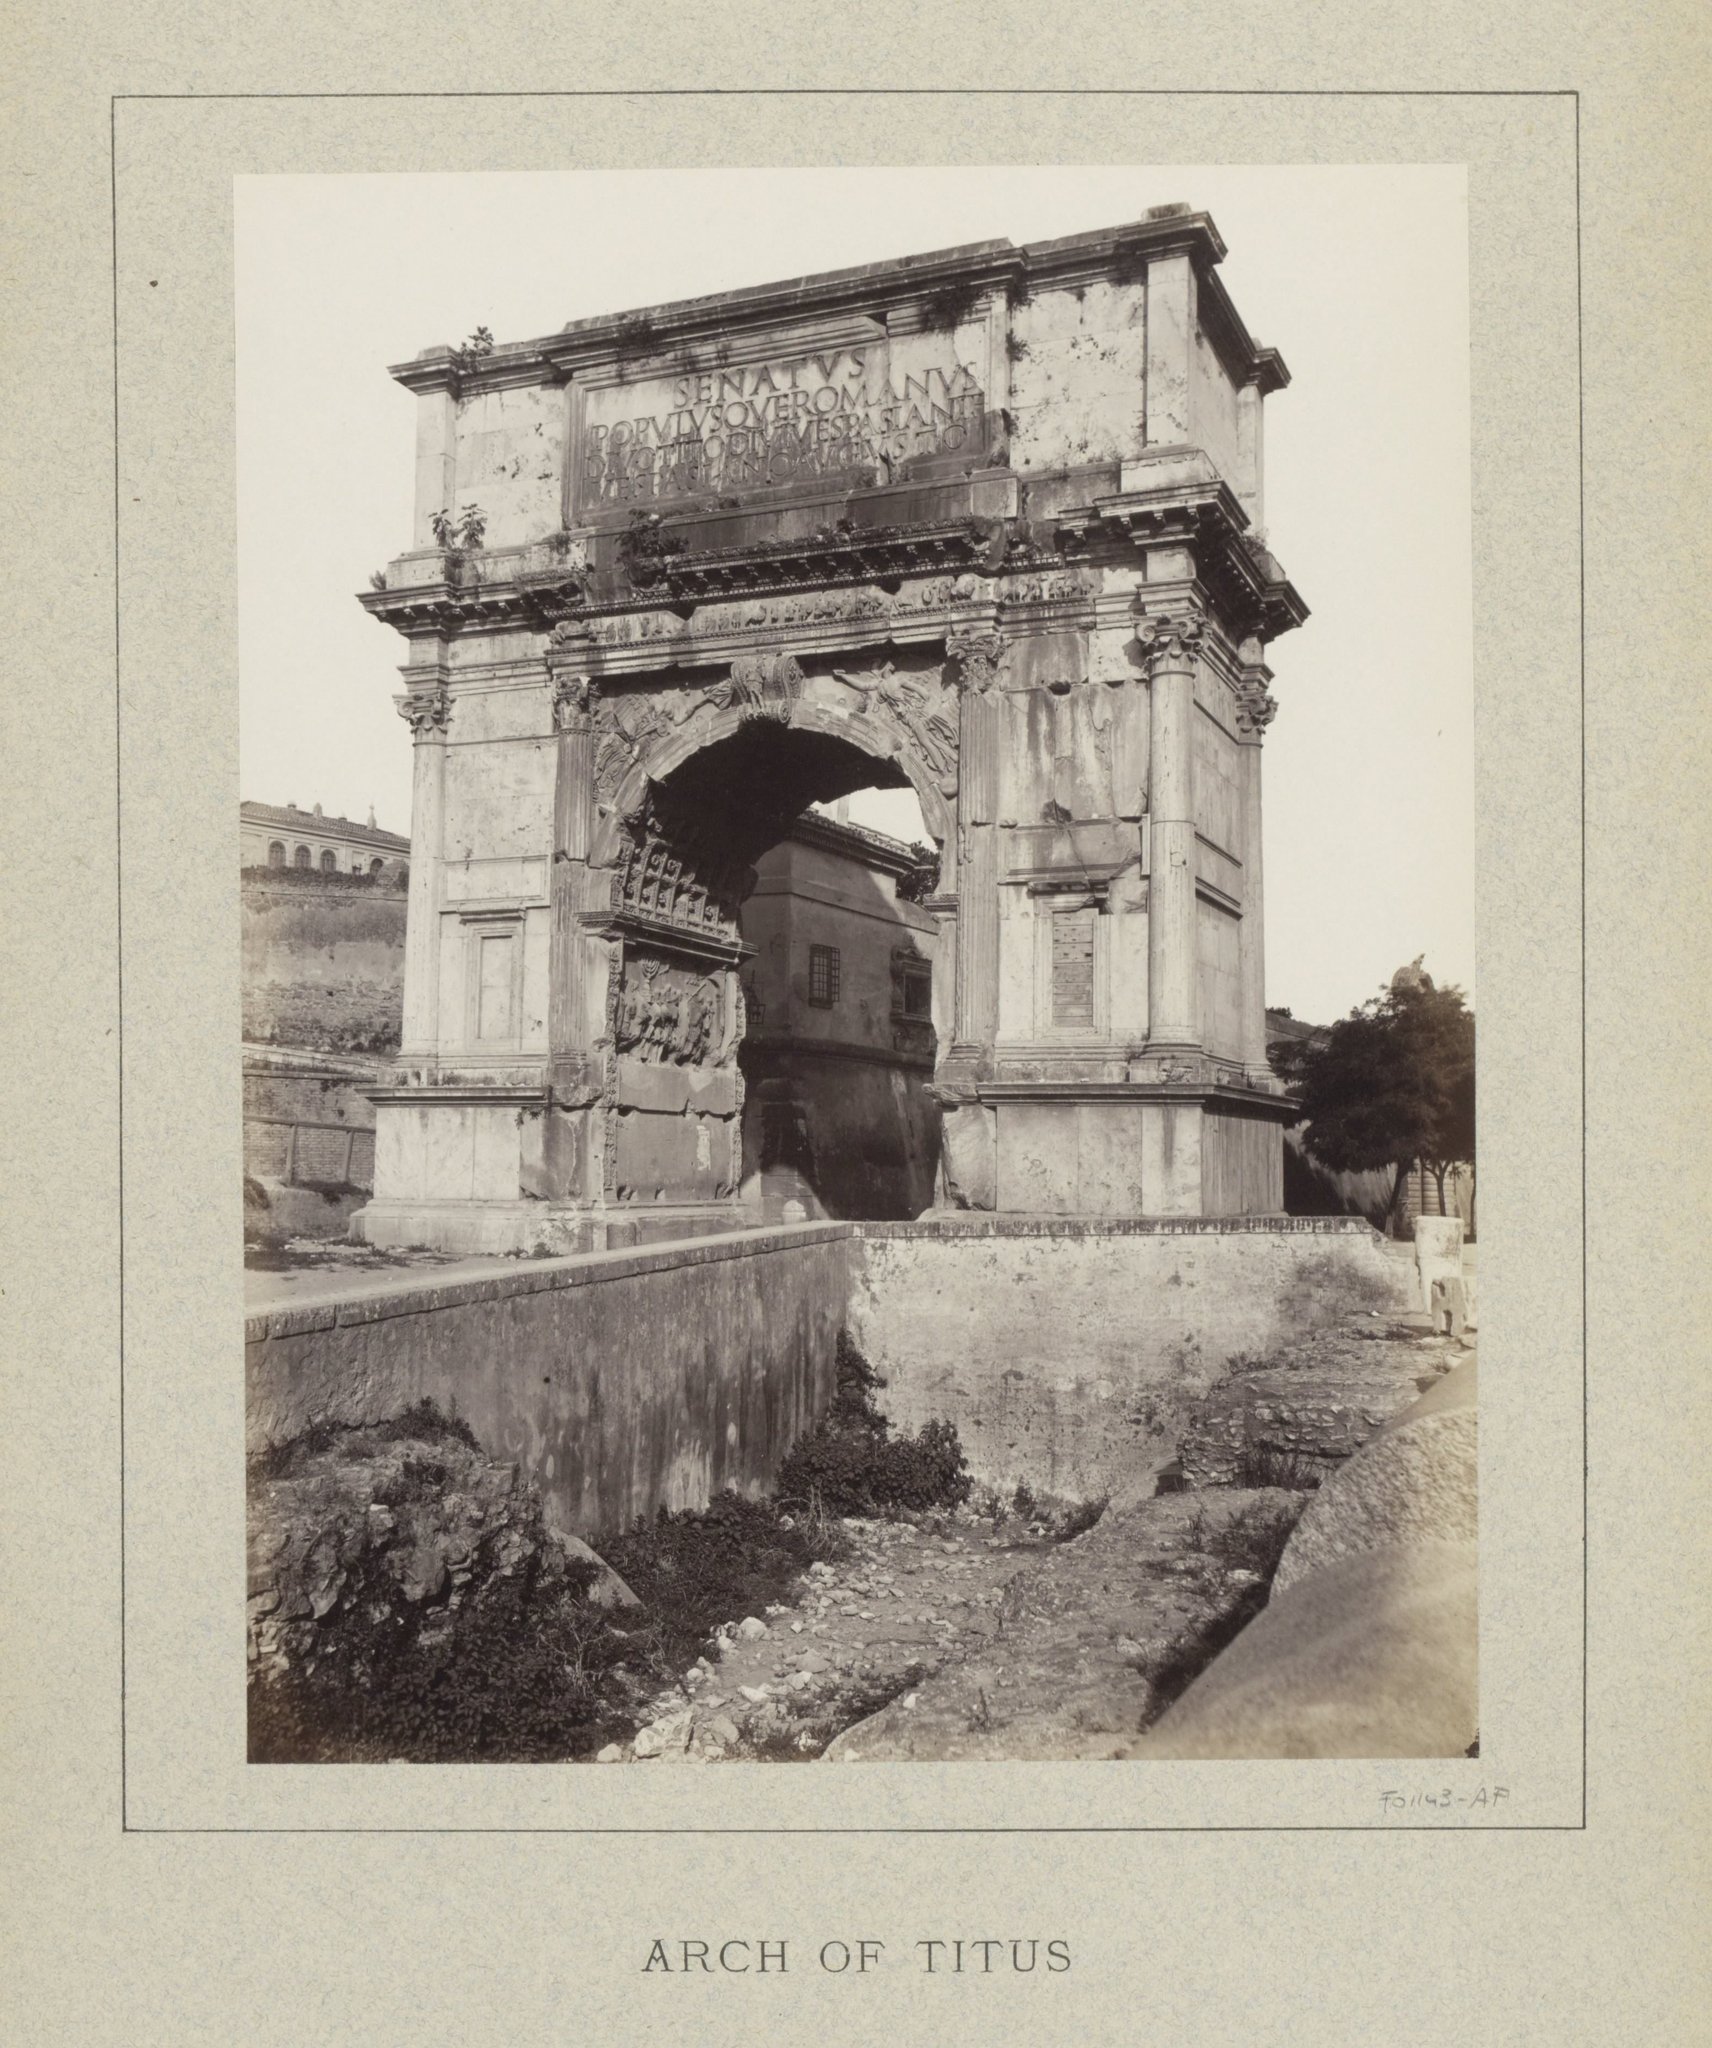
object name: photograph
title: Arch of Titus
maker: Anonymous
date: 1860-1900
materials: photographic support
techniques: albumen print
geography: rome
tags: triumphal arch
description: Onderdeel van Fotoalbum met opnames van bezienswaardigheden en kunstwerken in Rome.